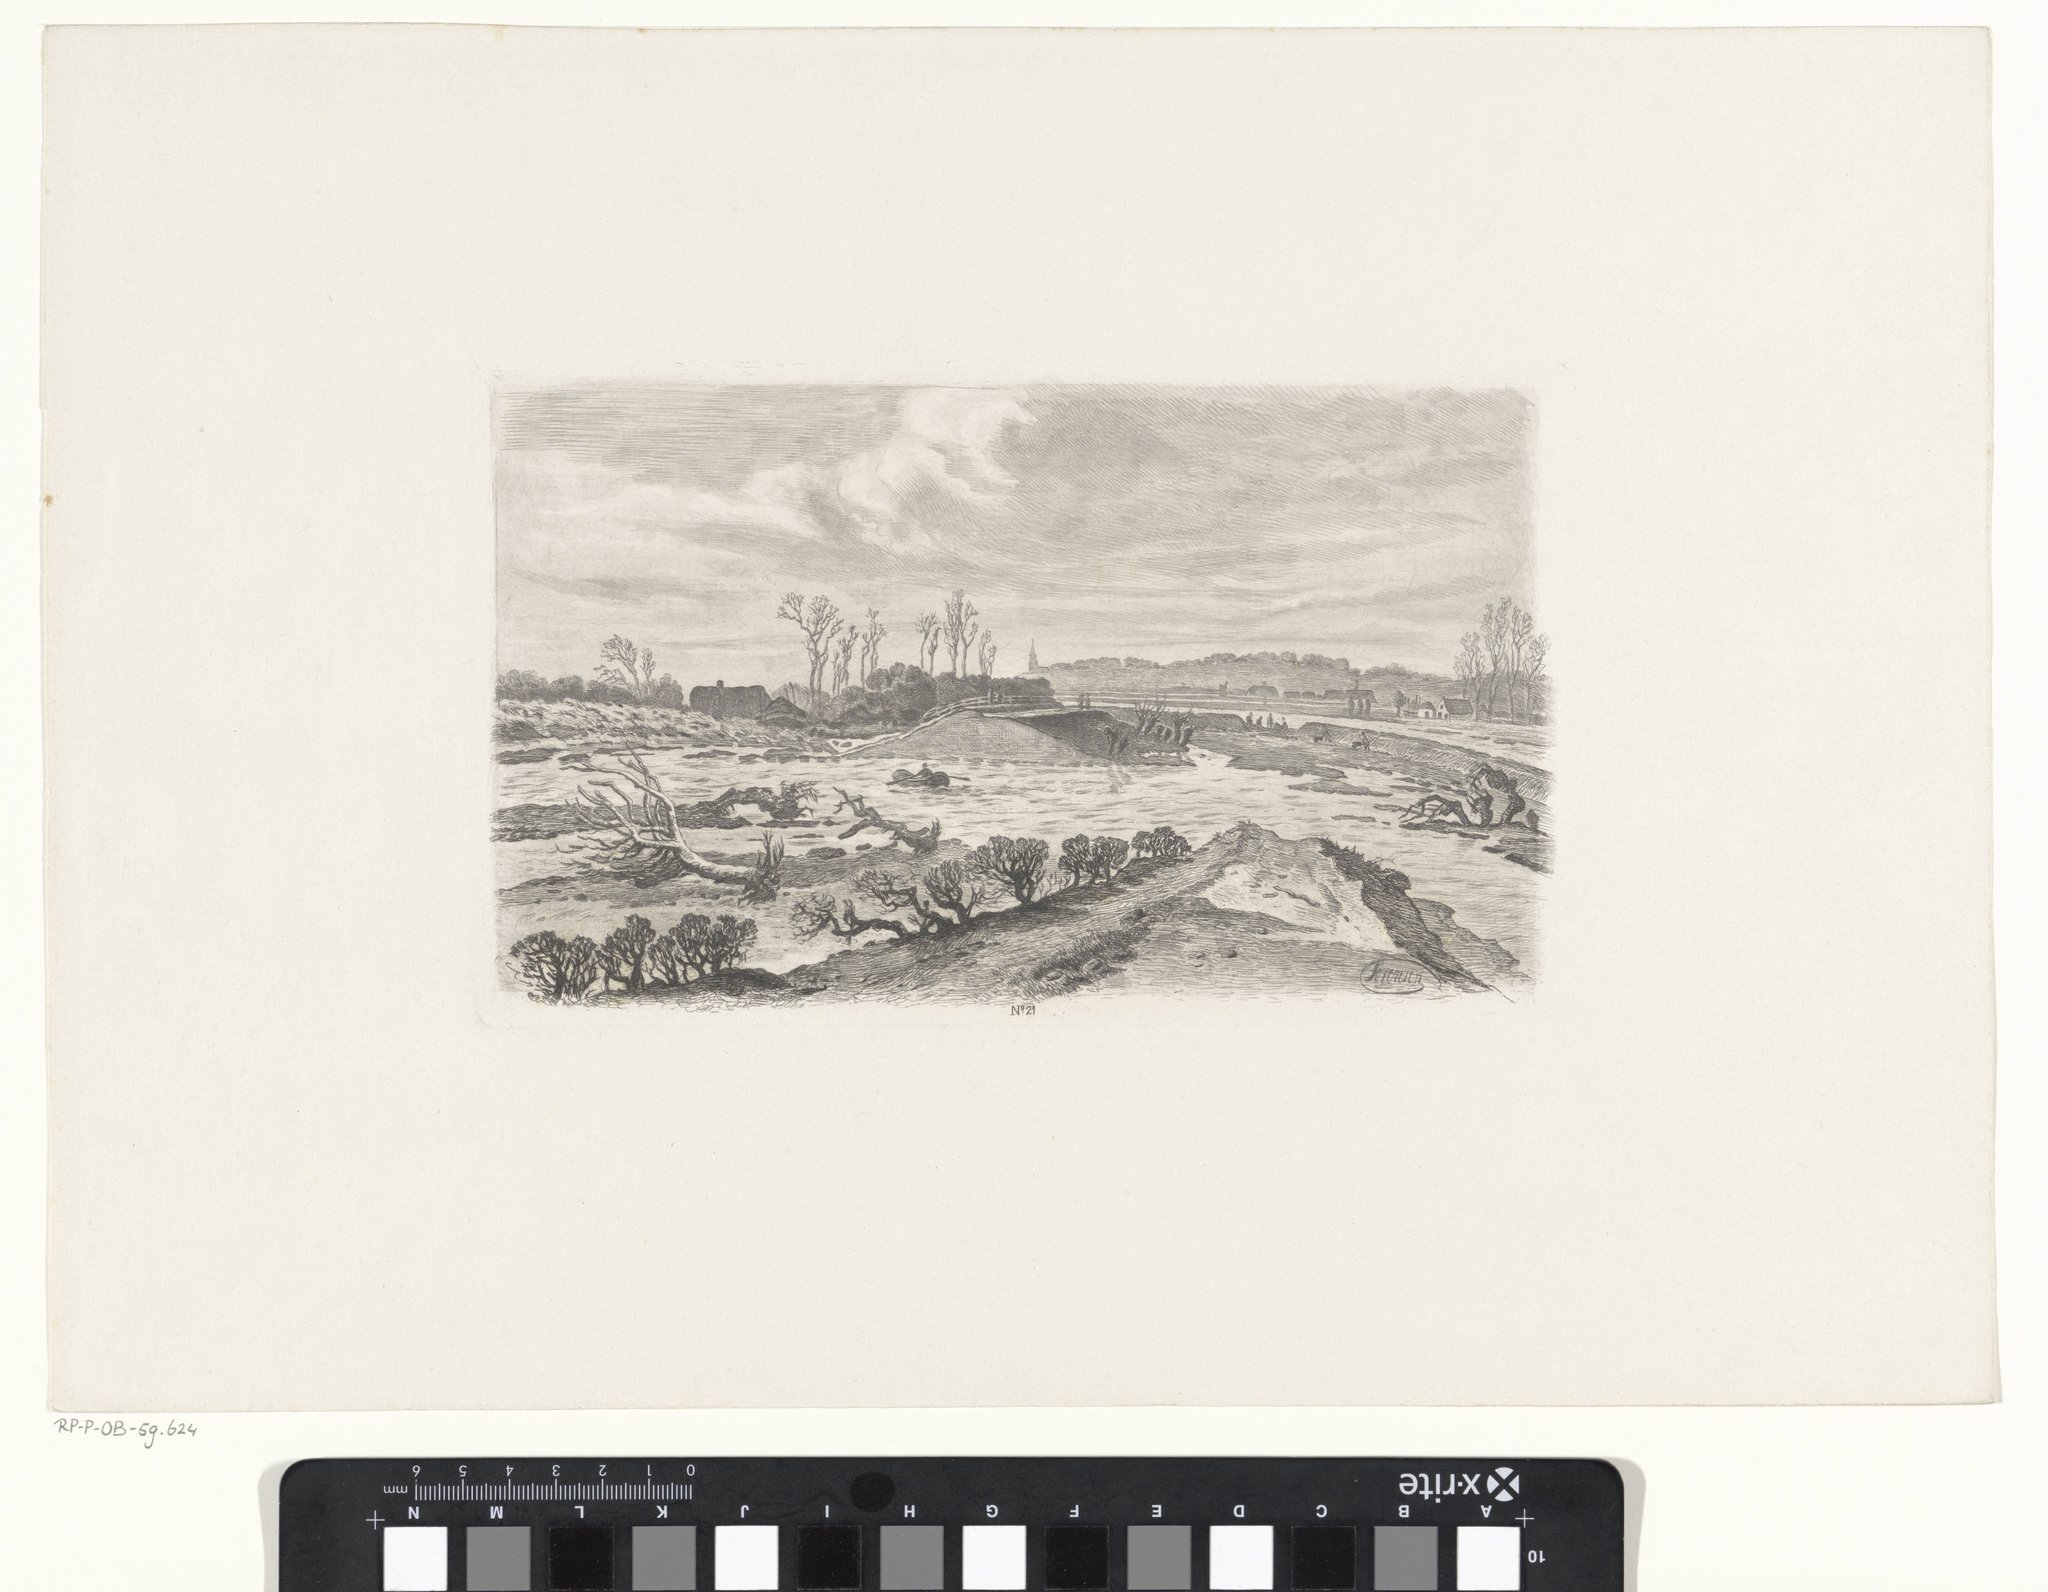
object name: print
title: Overstroomd landschap, nr. 21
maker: jacobus sörensen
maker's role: painter, print maker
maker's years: 1812-1857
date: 1827-1857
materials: paper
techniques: etching, intaglio, roulette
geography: amsterdam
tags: the flood and destruction of mankind ~ story of noah (genesis 7:10 - 8:17), river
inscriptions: collector's mark: Lugt 2228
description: Overstroomd rivierenlandschap met ontwortelde bomen. Mannen met kruiwagens lopen in de richting van een gat in de dijk. Op de achtergrond een dorpje en een kerk. Genummerd '21'.